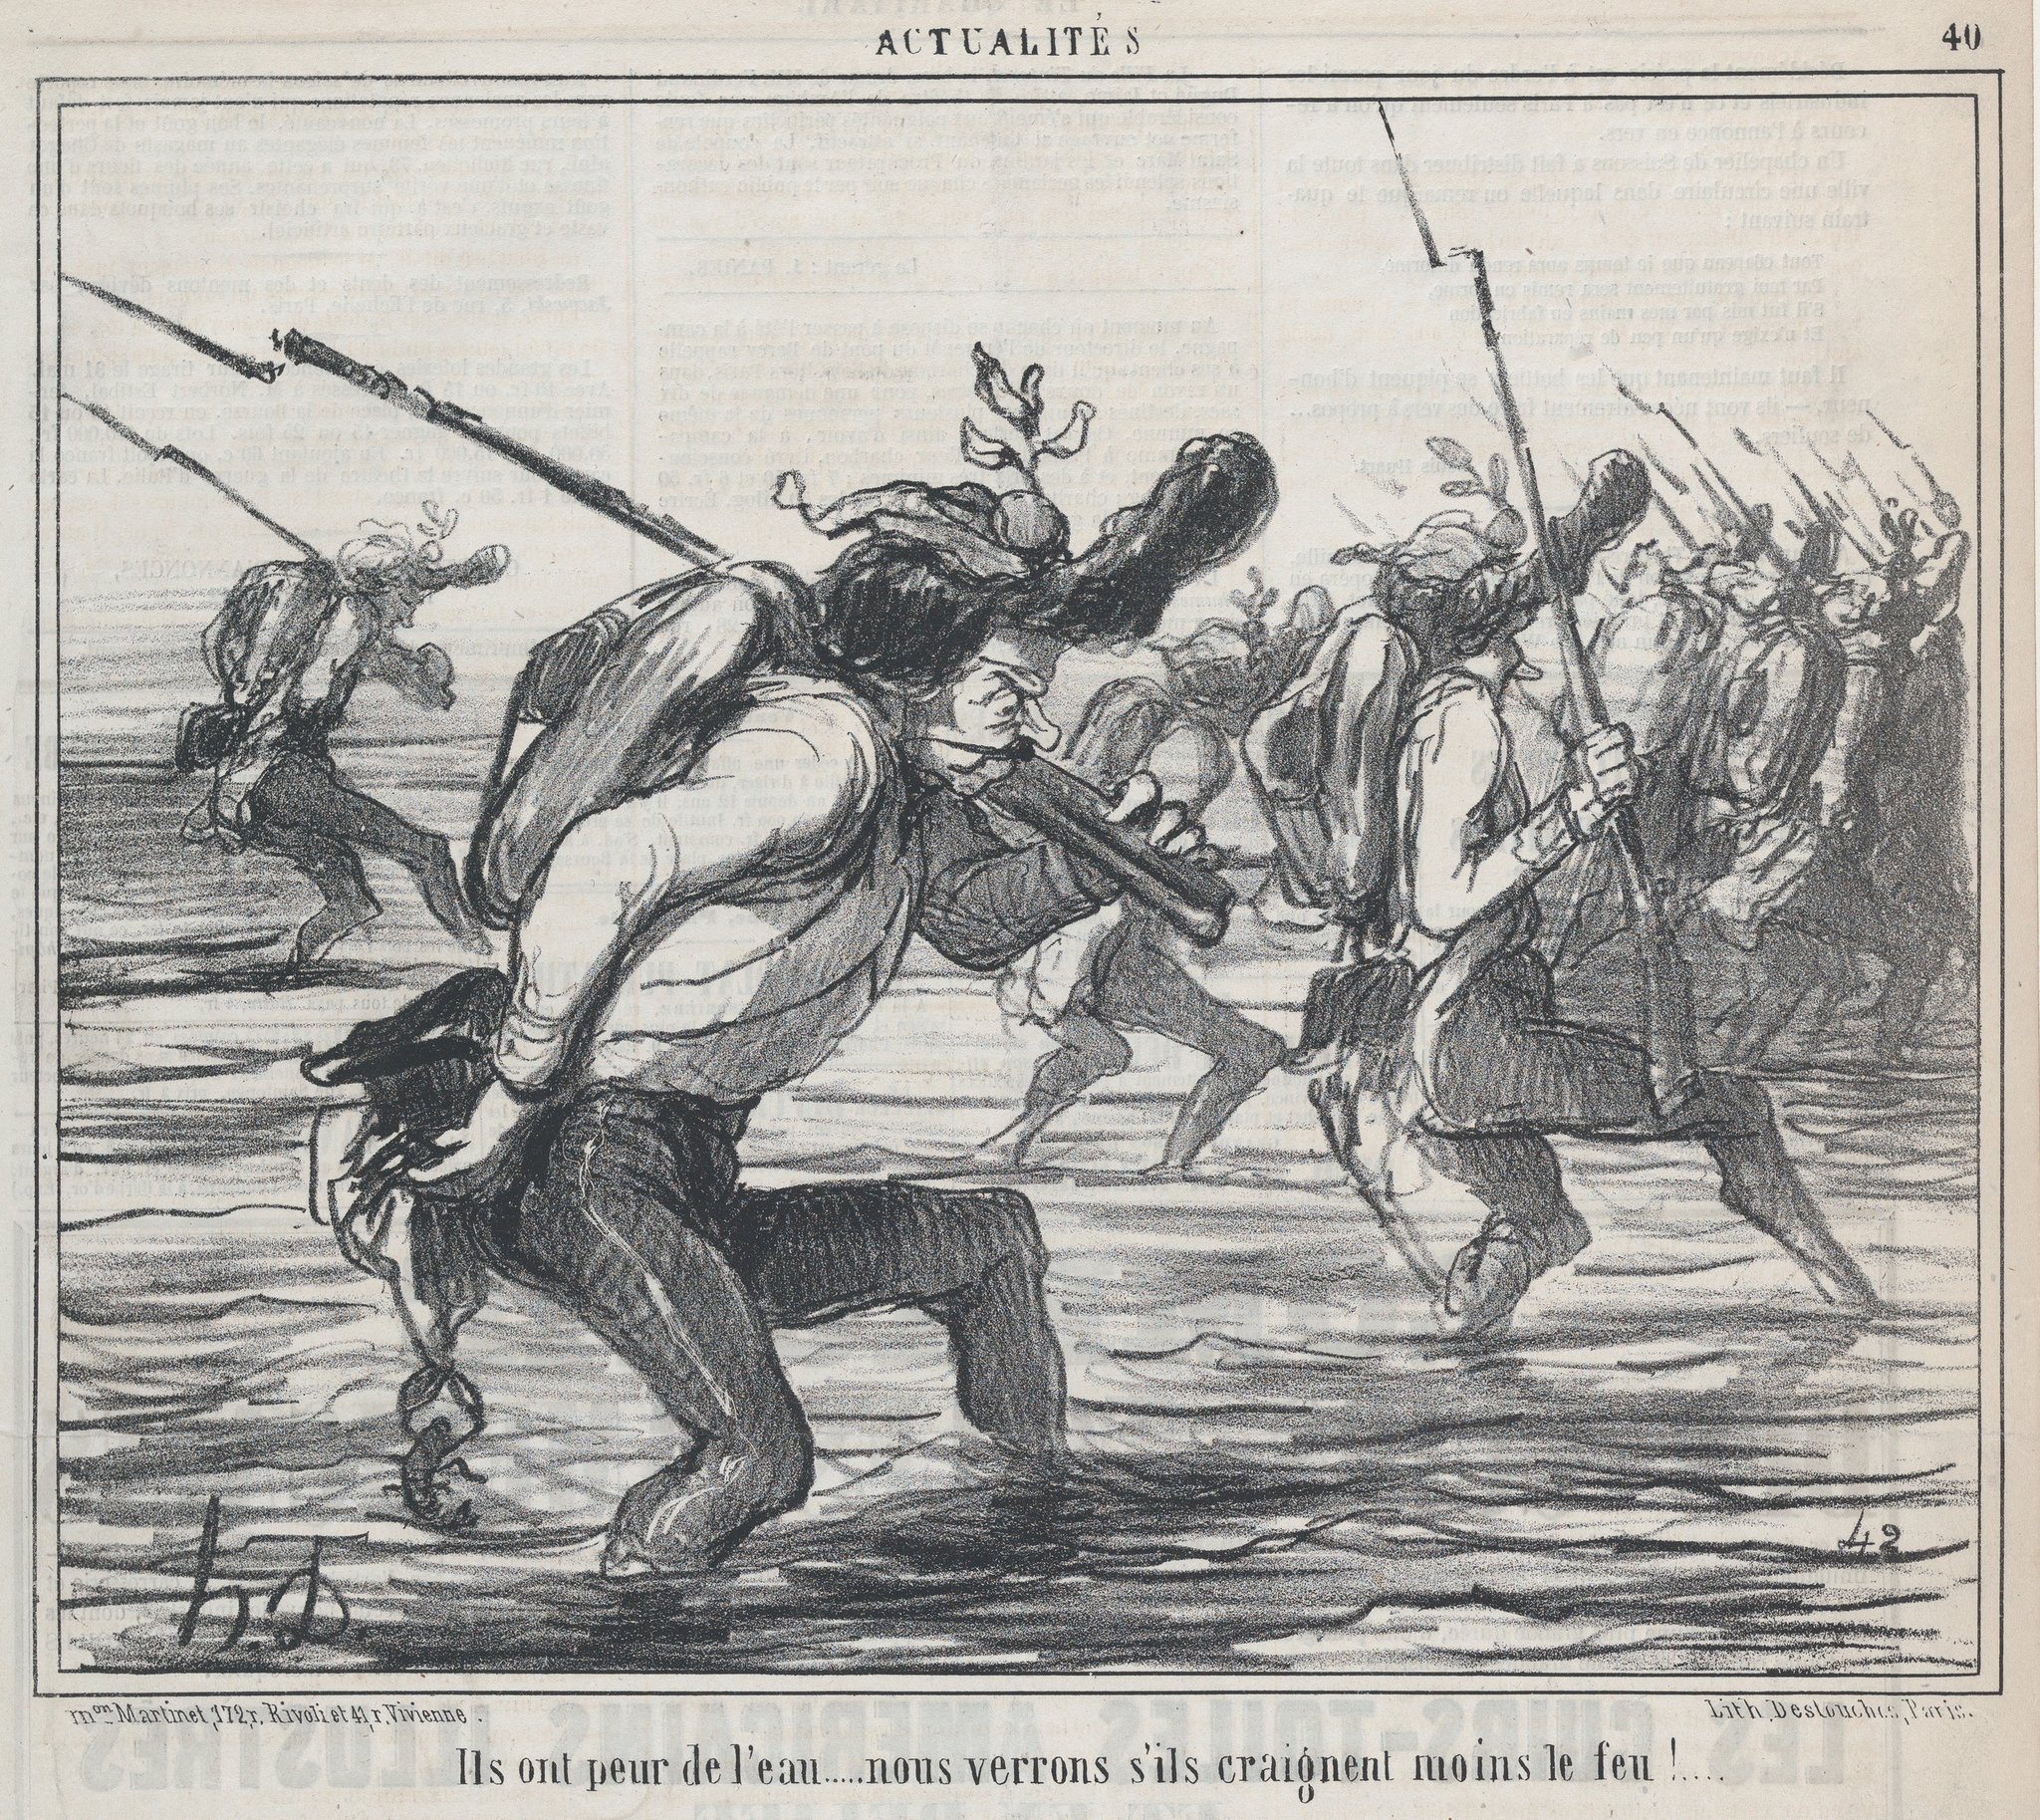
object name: print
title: Ils ont peur de l'eau..., from Actualités, published in Le Charivari, May 11, 1859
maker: honoré daumier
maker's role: artist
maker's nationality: french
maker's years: 1808-1879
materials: paper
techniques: lithograph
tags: satire,men